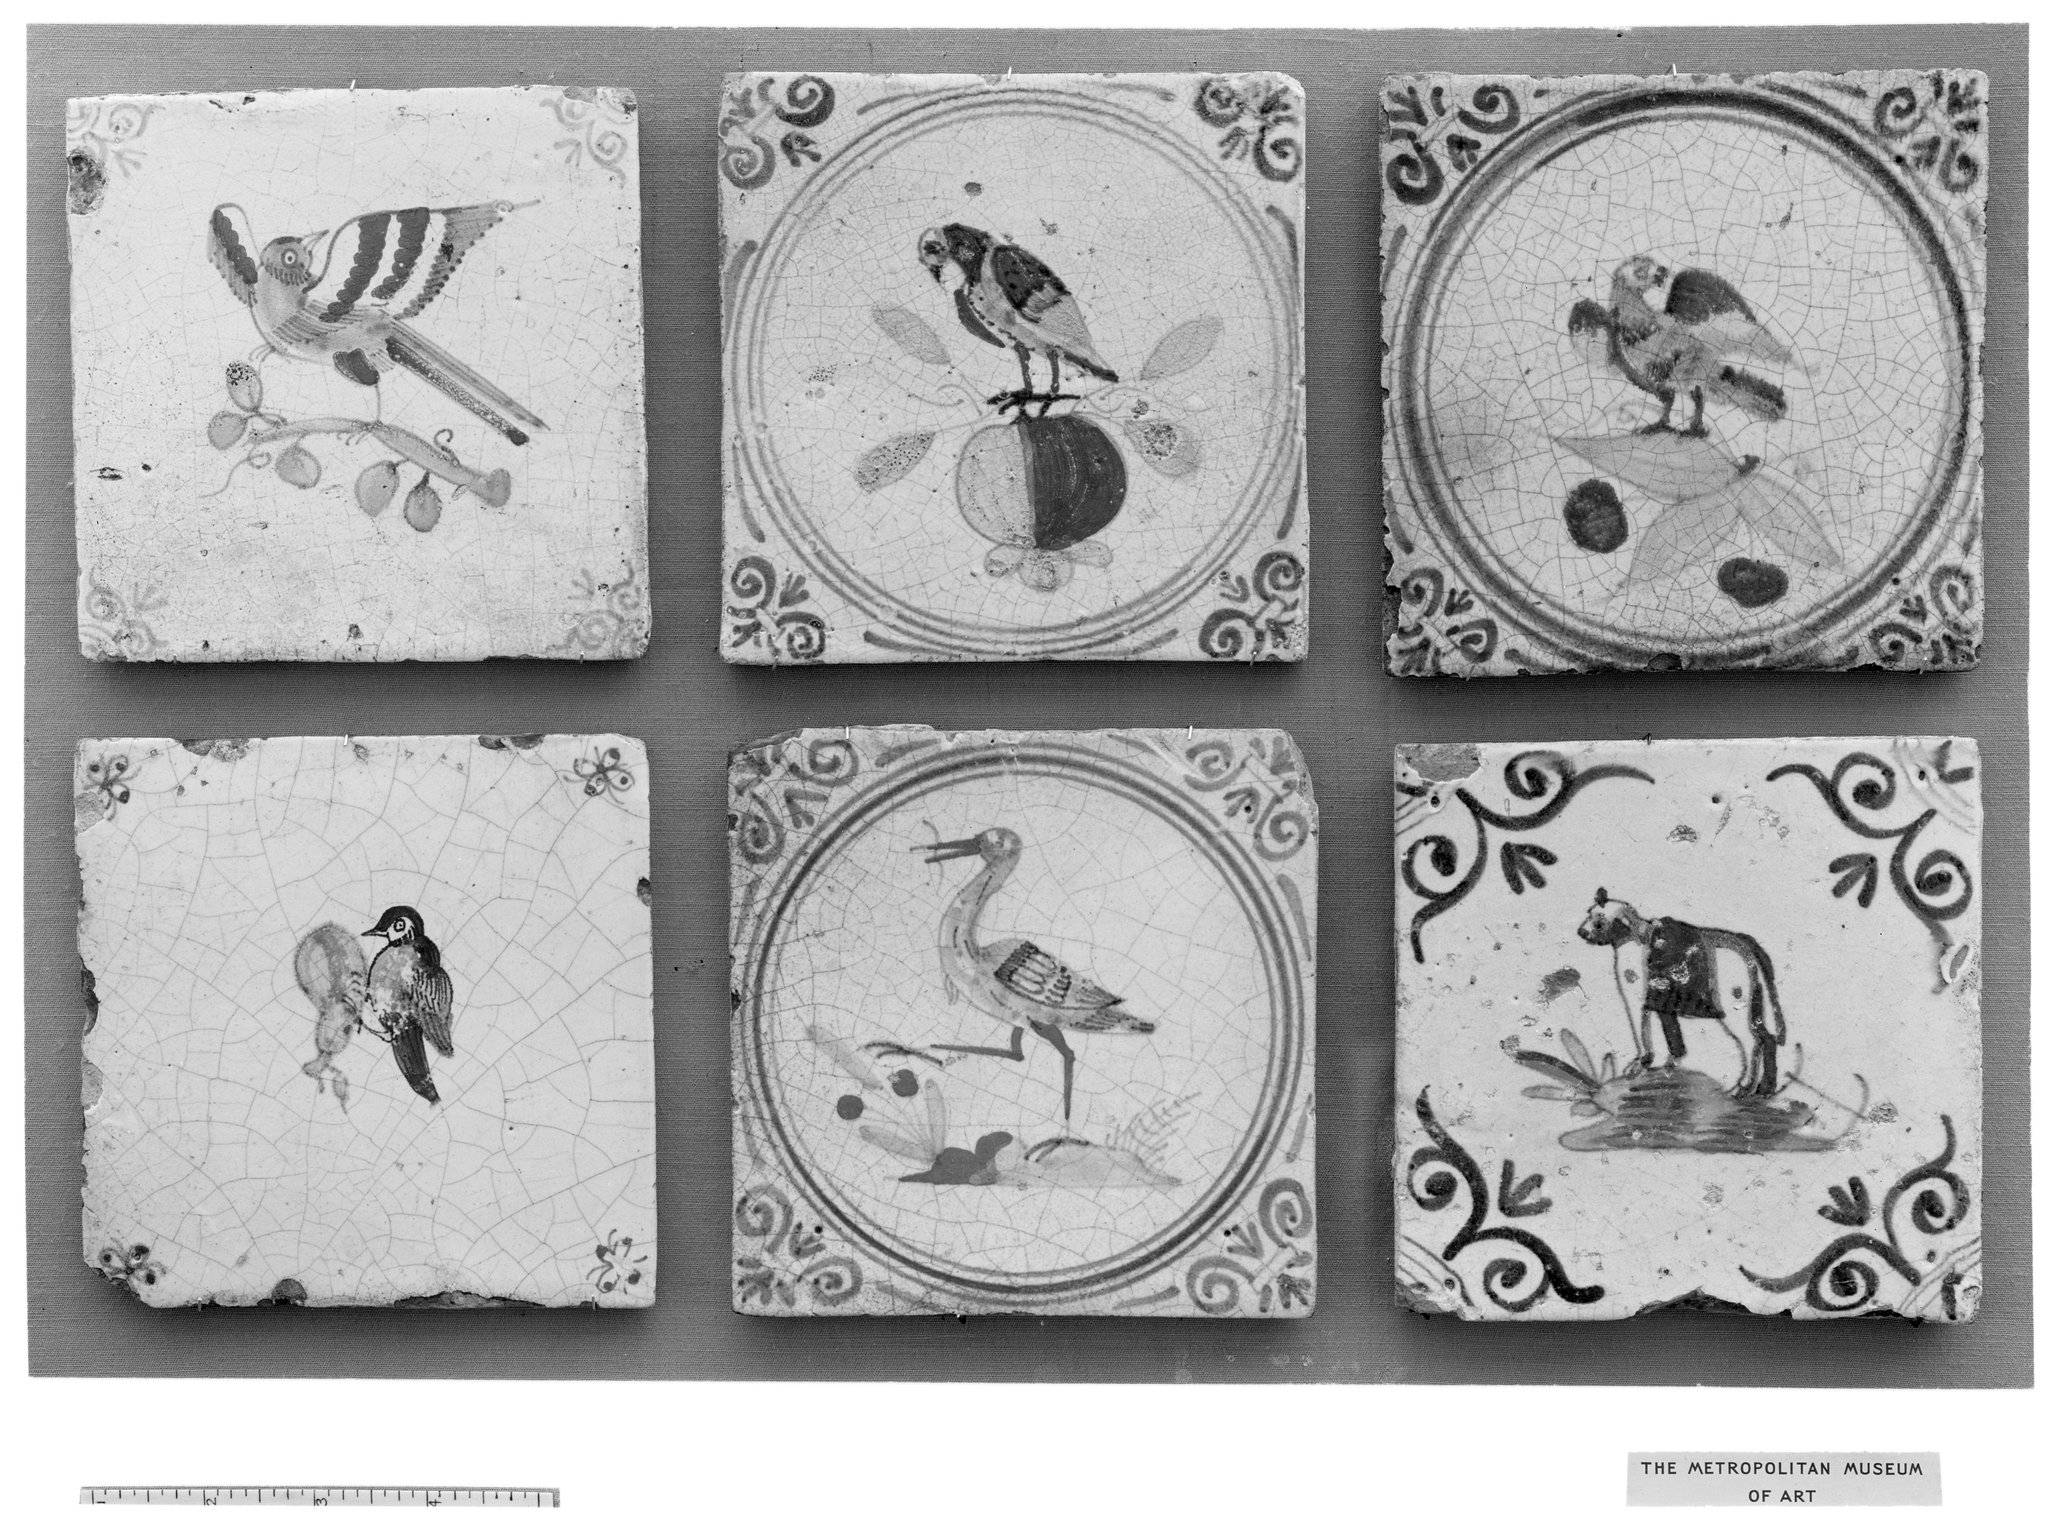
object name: tile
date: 1620-1640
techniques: glazing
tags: birds